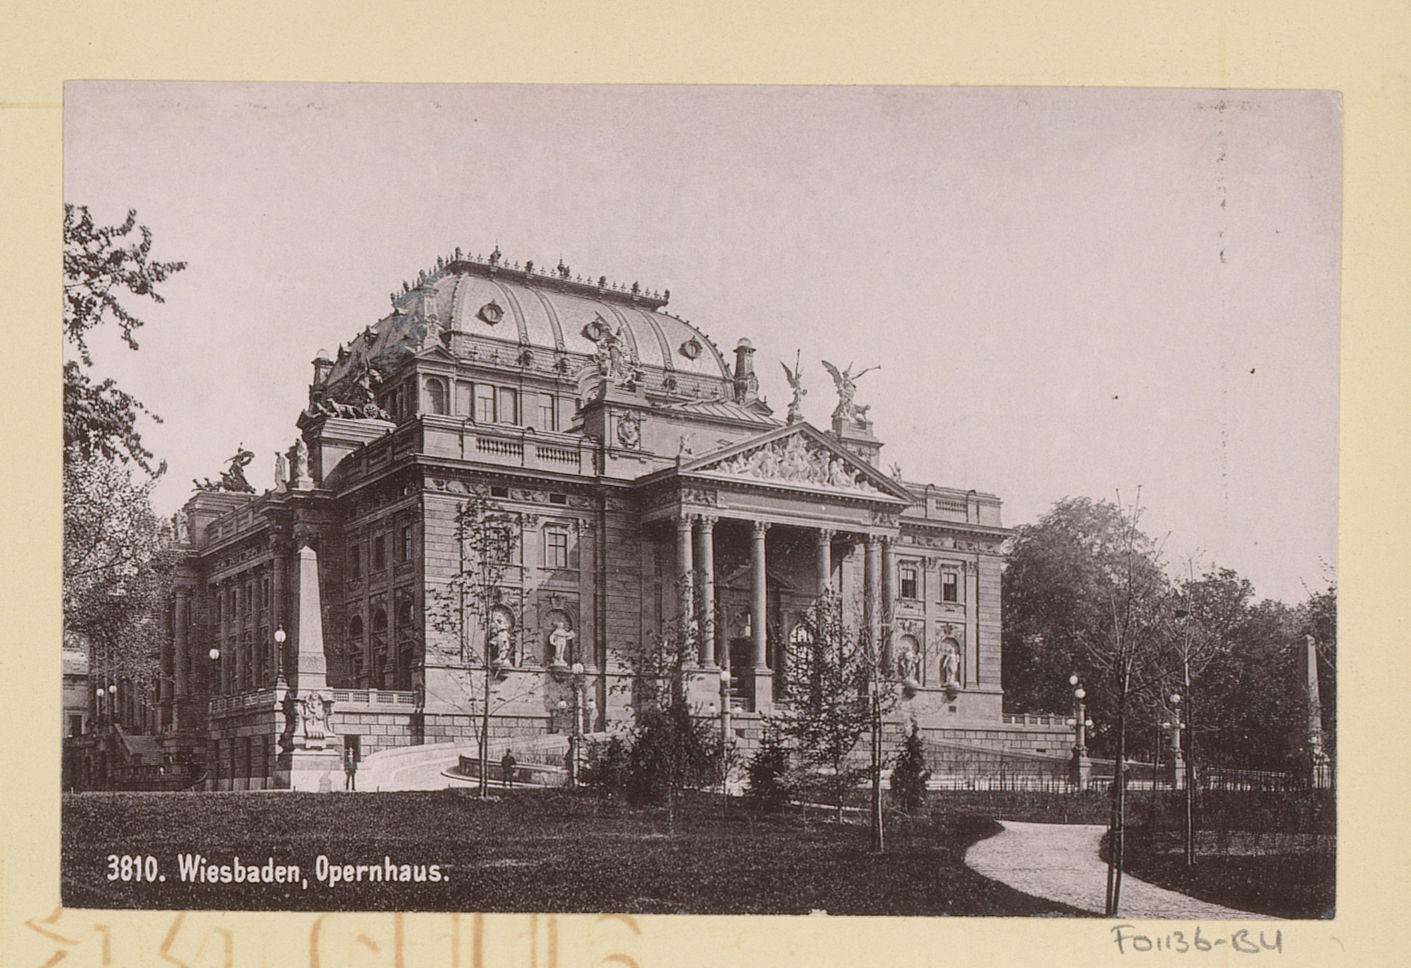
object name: photomechanical print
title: Exterieur van het operagebouw van Wiesbaden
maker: Anonymous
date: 1880-1895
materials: paper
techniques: photograph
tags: façade (of house or building), opera house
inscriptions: number: ‘3810’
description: Onderdeel van Fotoalbum met opnames van bezienswaardigheden in België, Duitsland en Noorwegen.